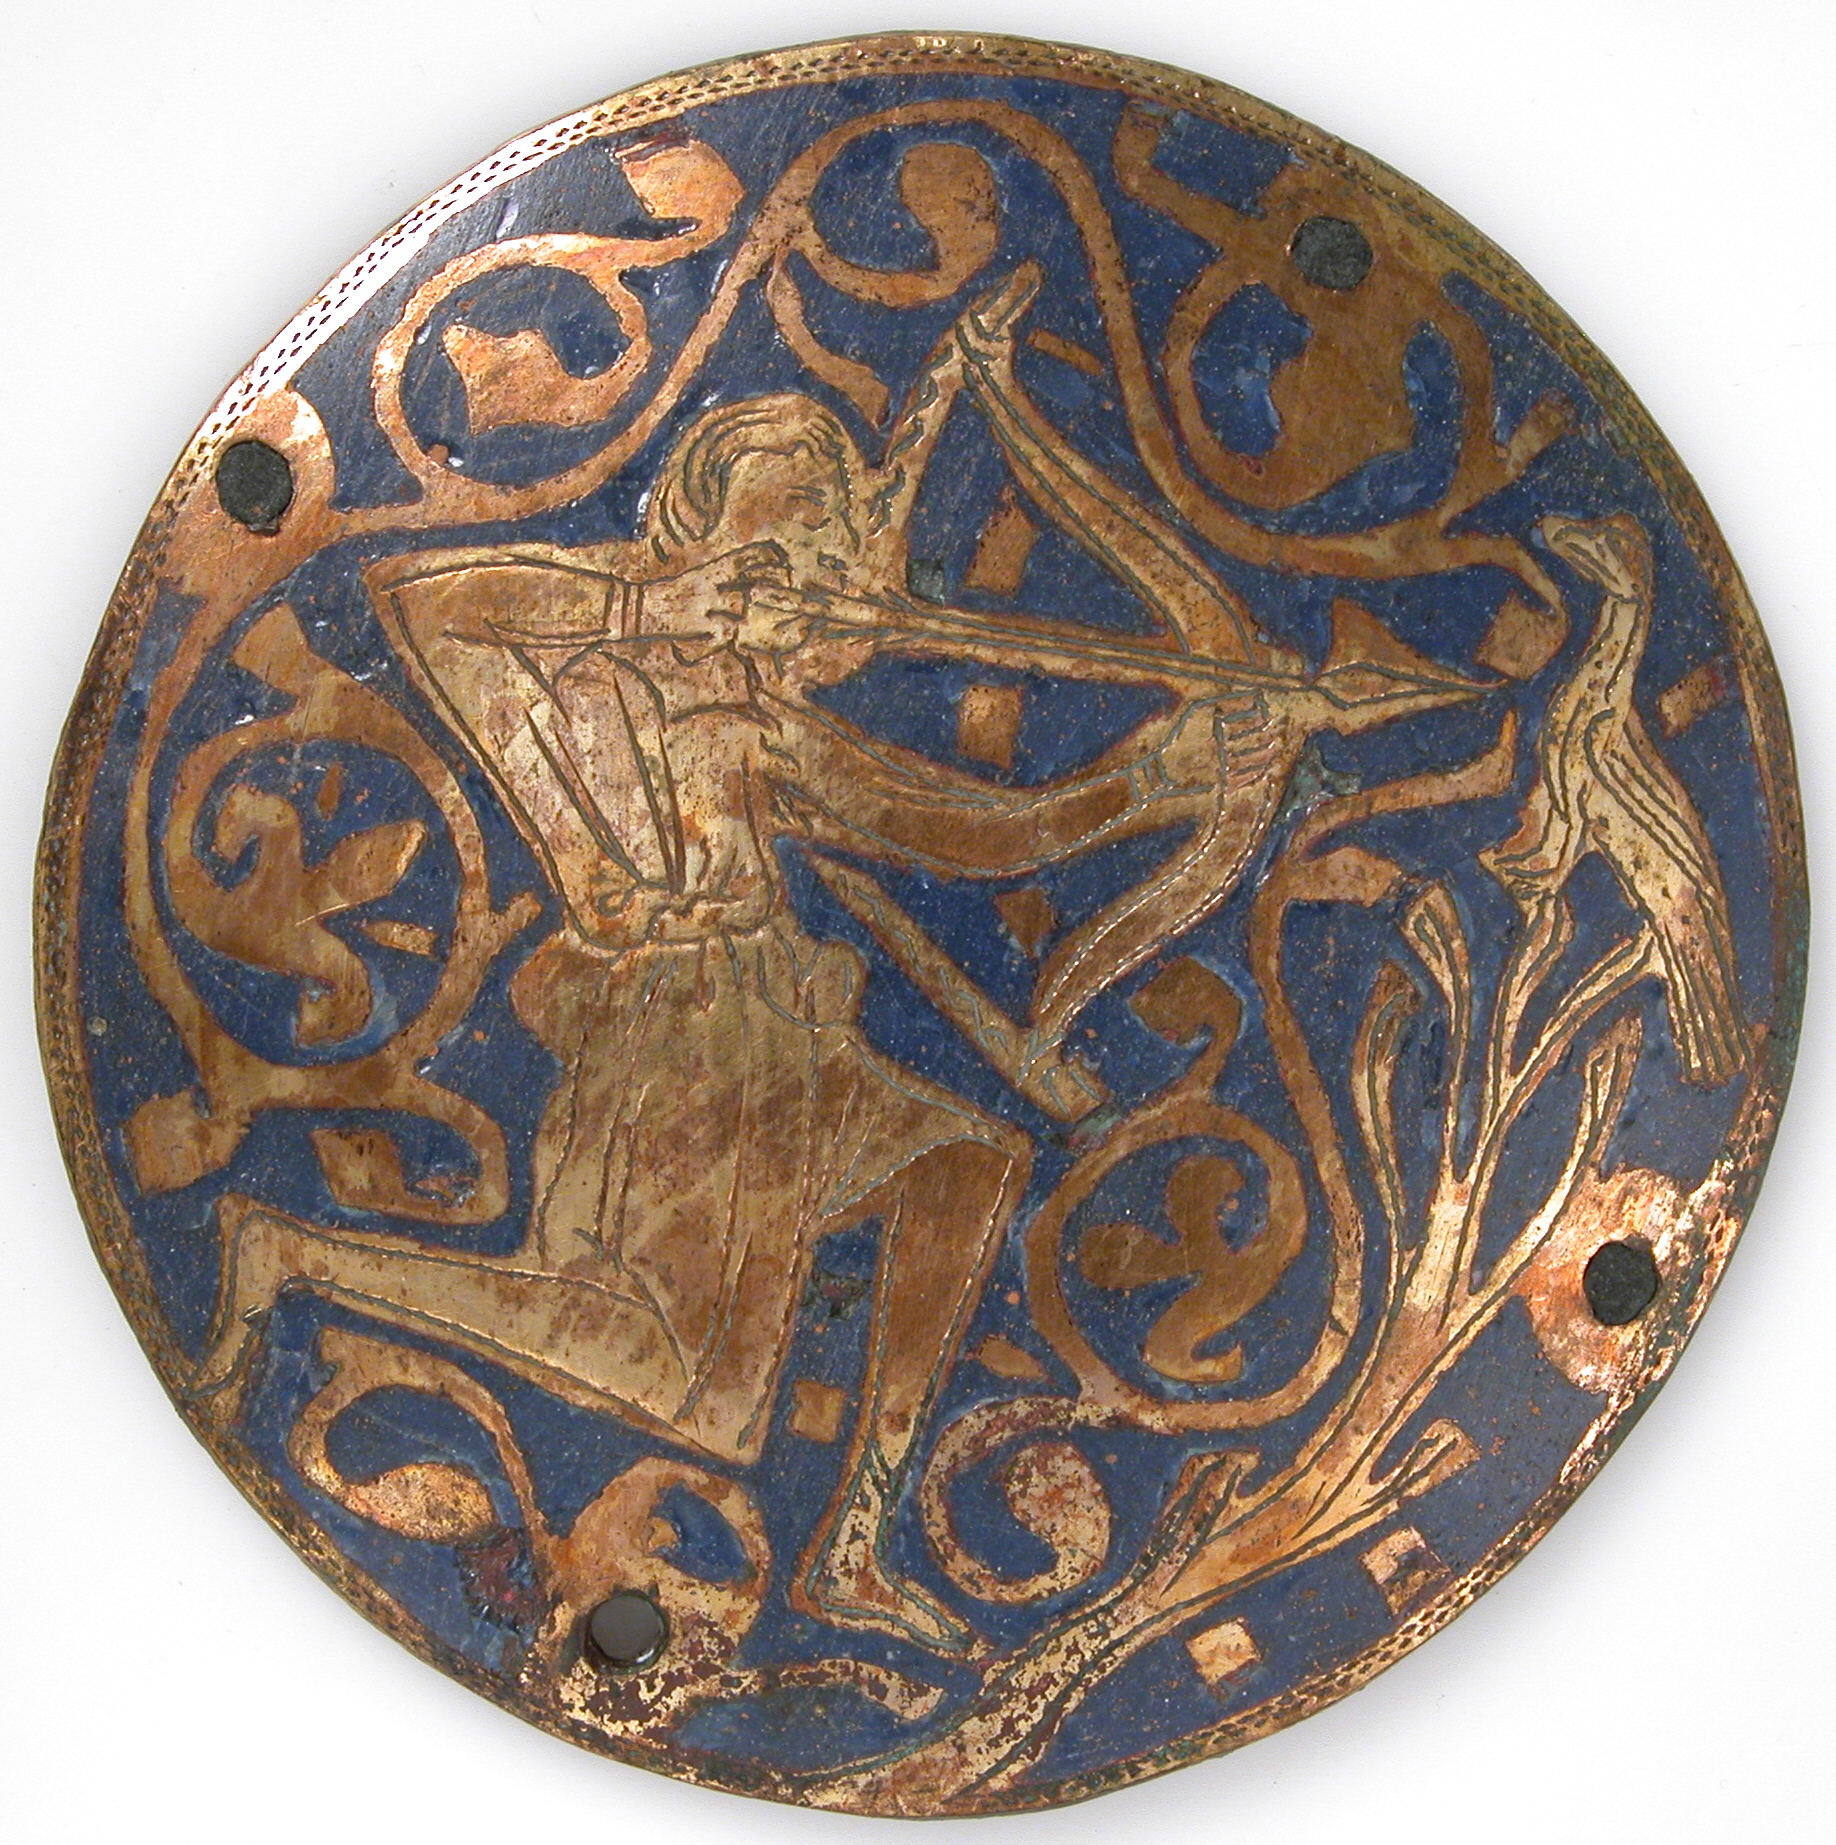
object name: medallion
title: Medallion with Archer Shooting Bird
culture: french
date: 1240-1260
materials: copper, enamel, gilt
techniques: enamel, engraving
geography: france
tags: birds,bow and arrow,men,hunting